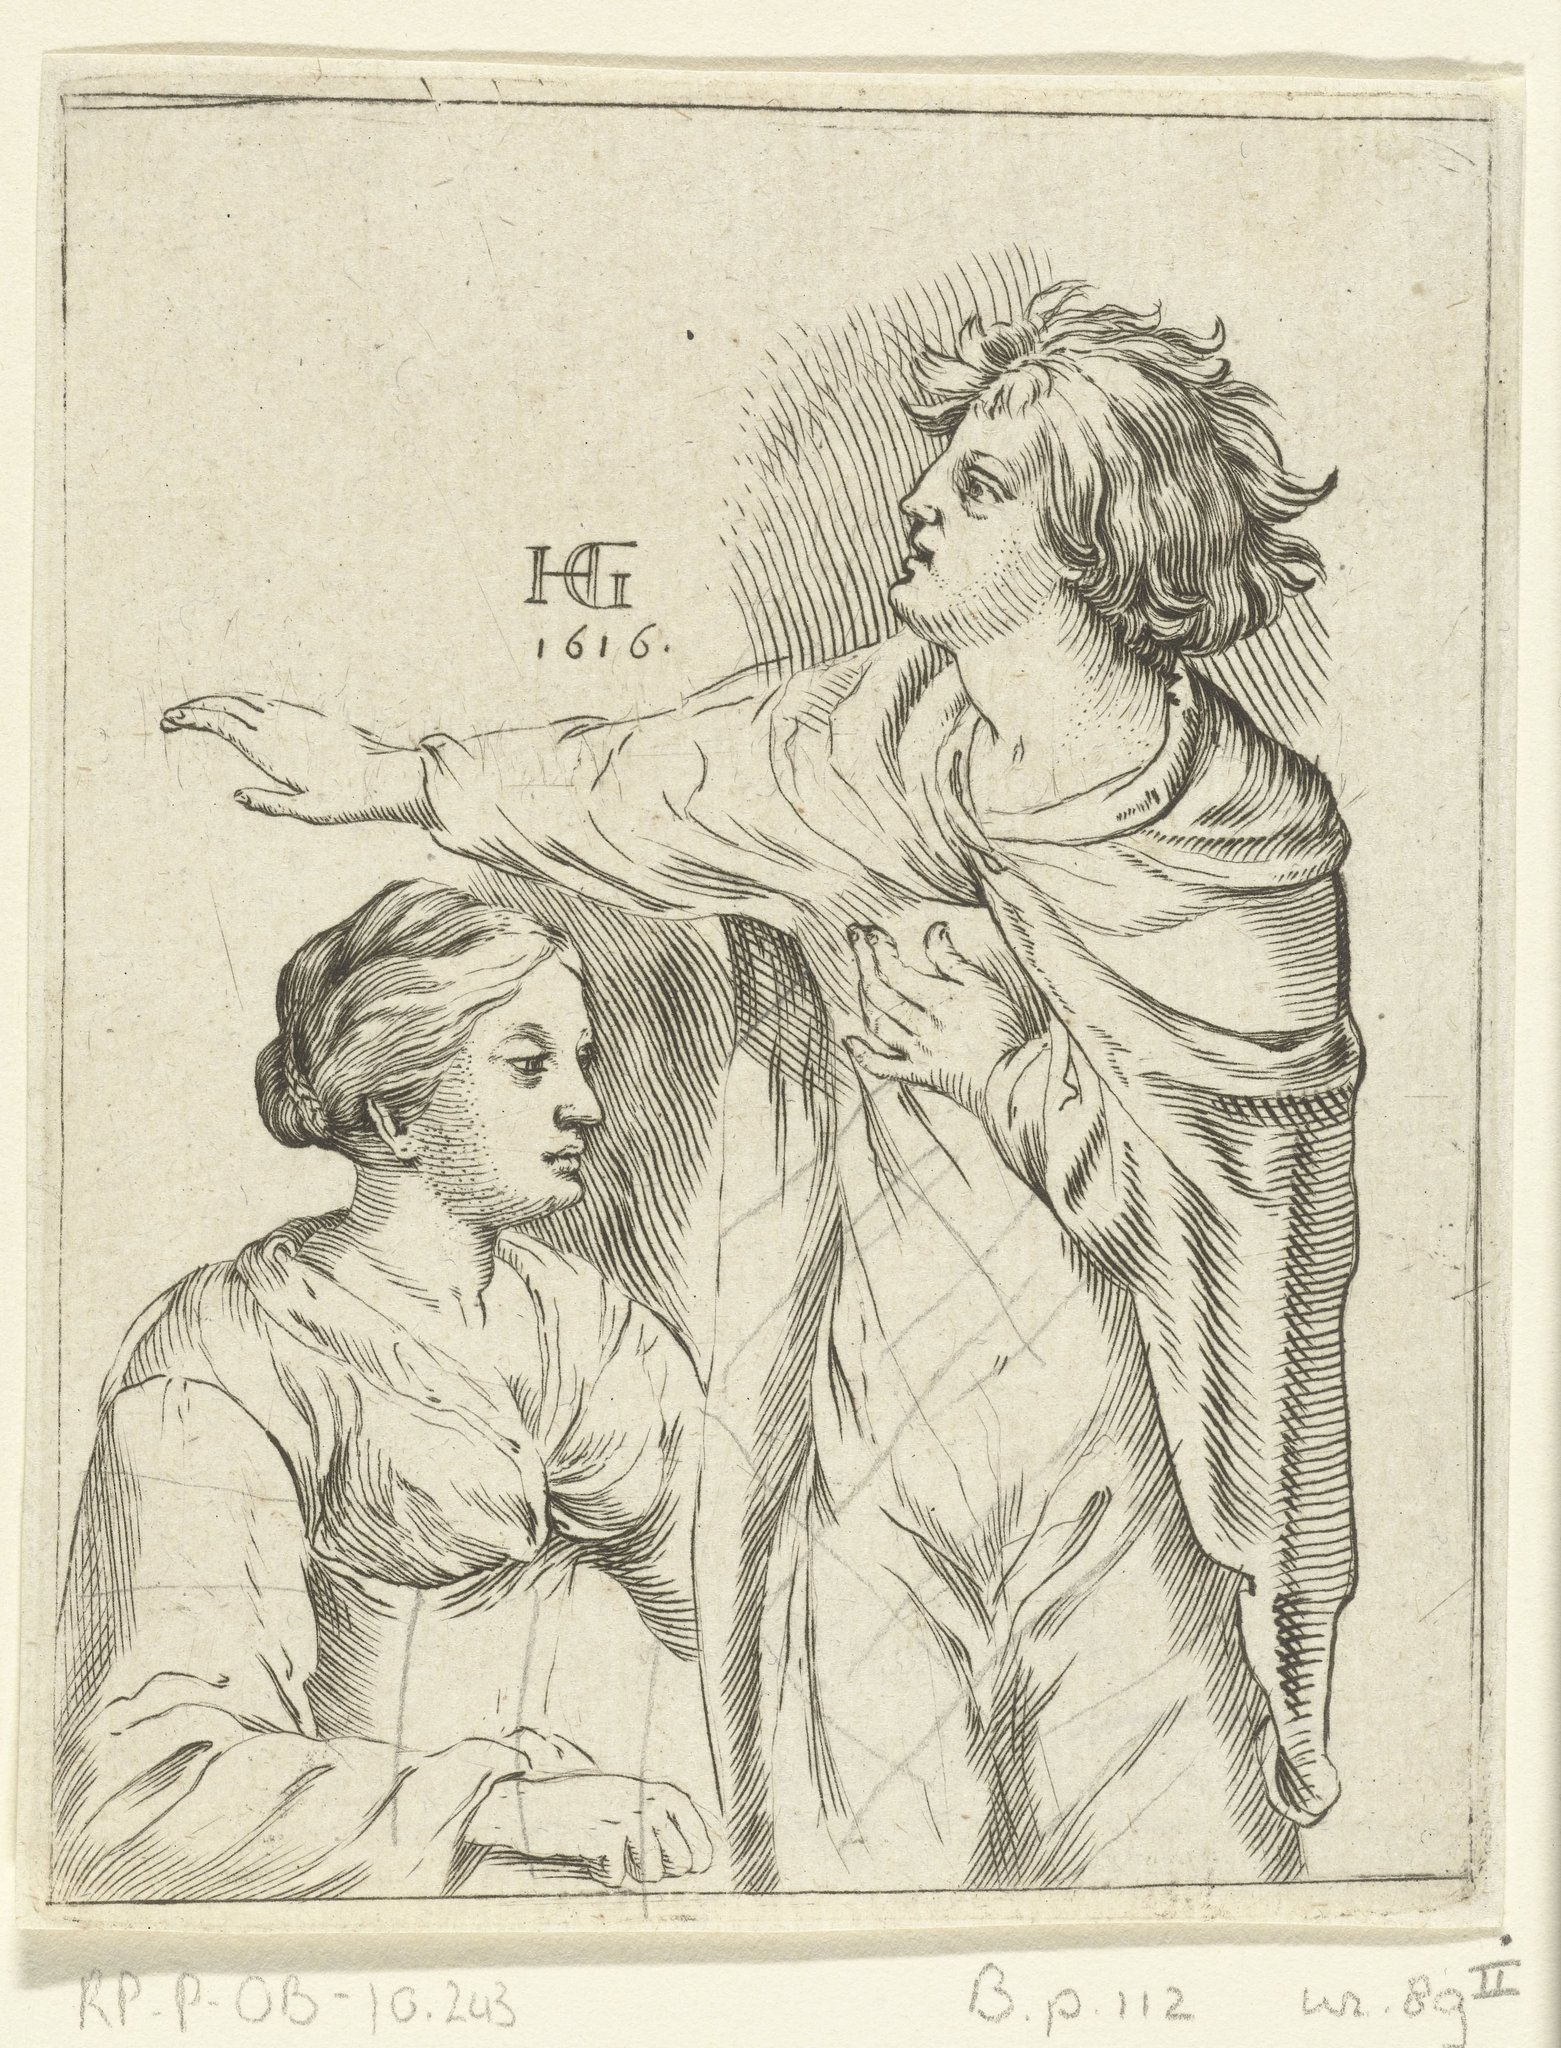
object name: print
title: Studie voor een jonge vrouw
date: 1616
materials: paper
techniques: engraving, etching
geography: netherlands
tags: anonymous historical person portrayed alone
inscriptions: collector's mark: Lugt 2228a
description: Studie van een jonge vrouw in een jurk: links een zittende jonge vrouw met opgestoken haar, rechts een staande jonge vrouw met los haar en uitgestoken rechterhand.